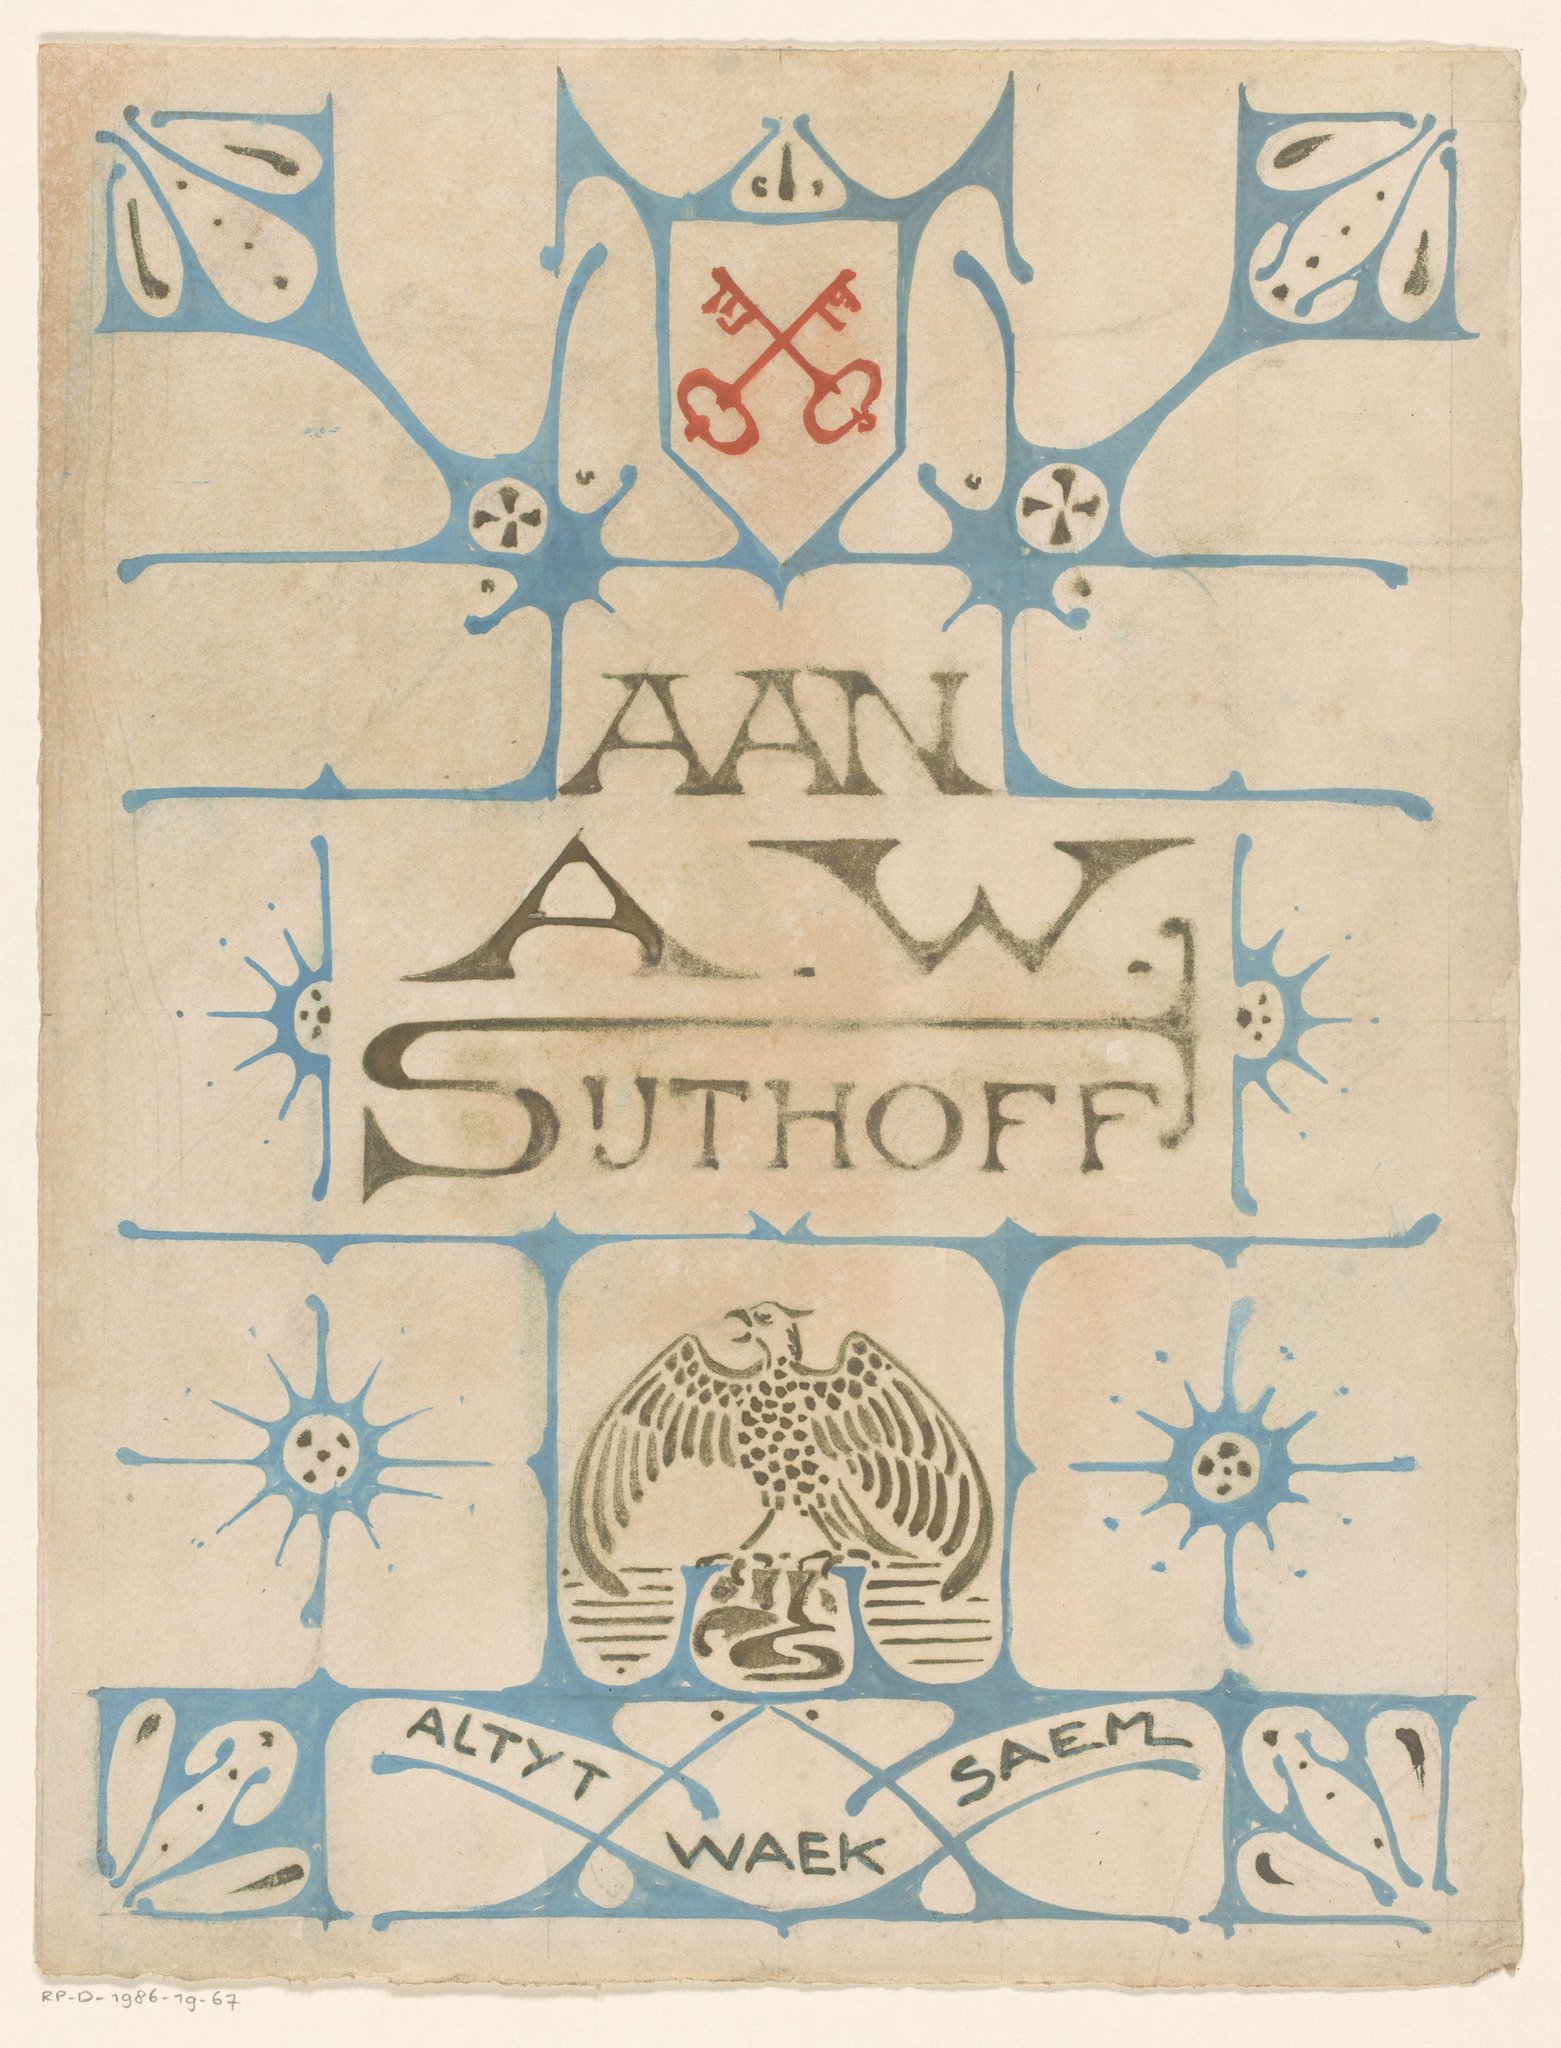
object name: drawing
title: Opdrachtblad voor een album voor A.W. Sijthoff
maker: reinier willem petrus de vries (1874-1953)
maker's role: draughtsman, print maker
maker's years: 1874-1953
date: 1902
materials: paint, paper, pencil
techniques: brush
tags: leiden, albertus willem sijthoff, coat of arms (as symbol of the state, etc.), predatory birds: eagle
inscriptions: collector's mark: ‘R:MVS.’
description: Ontwerp met gekruiste sleutels in het wapen van Leiden, een adelaar, twee zonnen en de zinspreuk van Sijthoff: 'Altyt Waek Saem'.